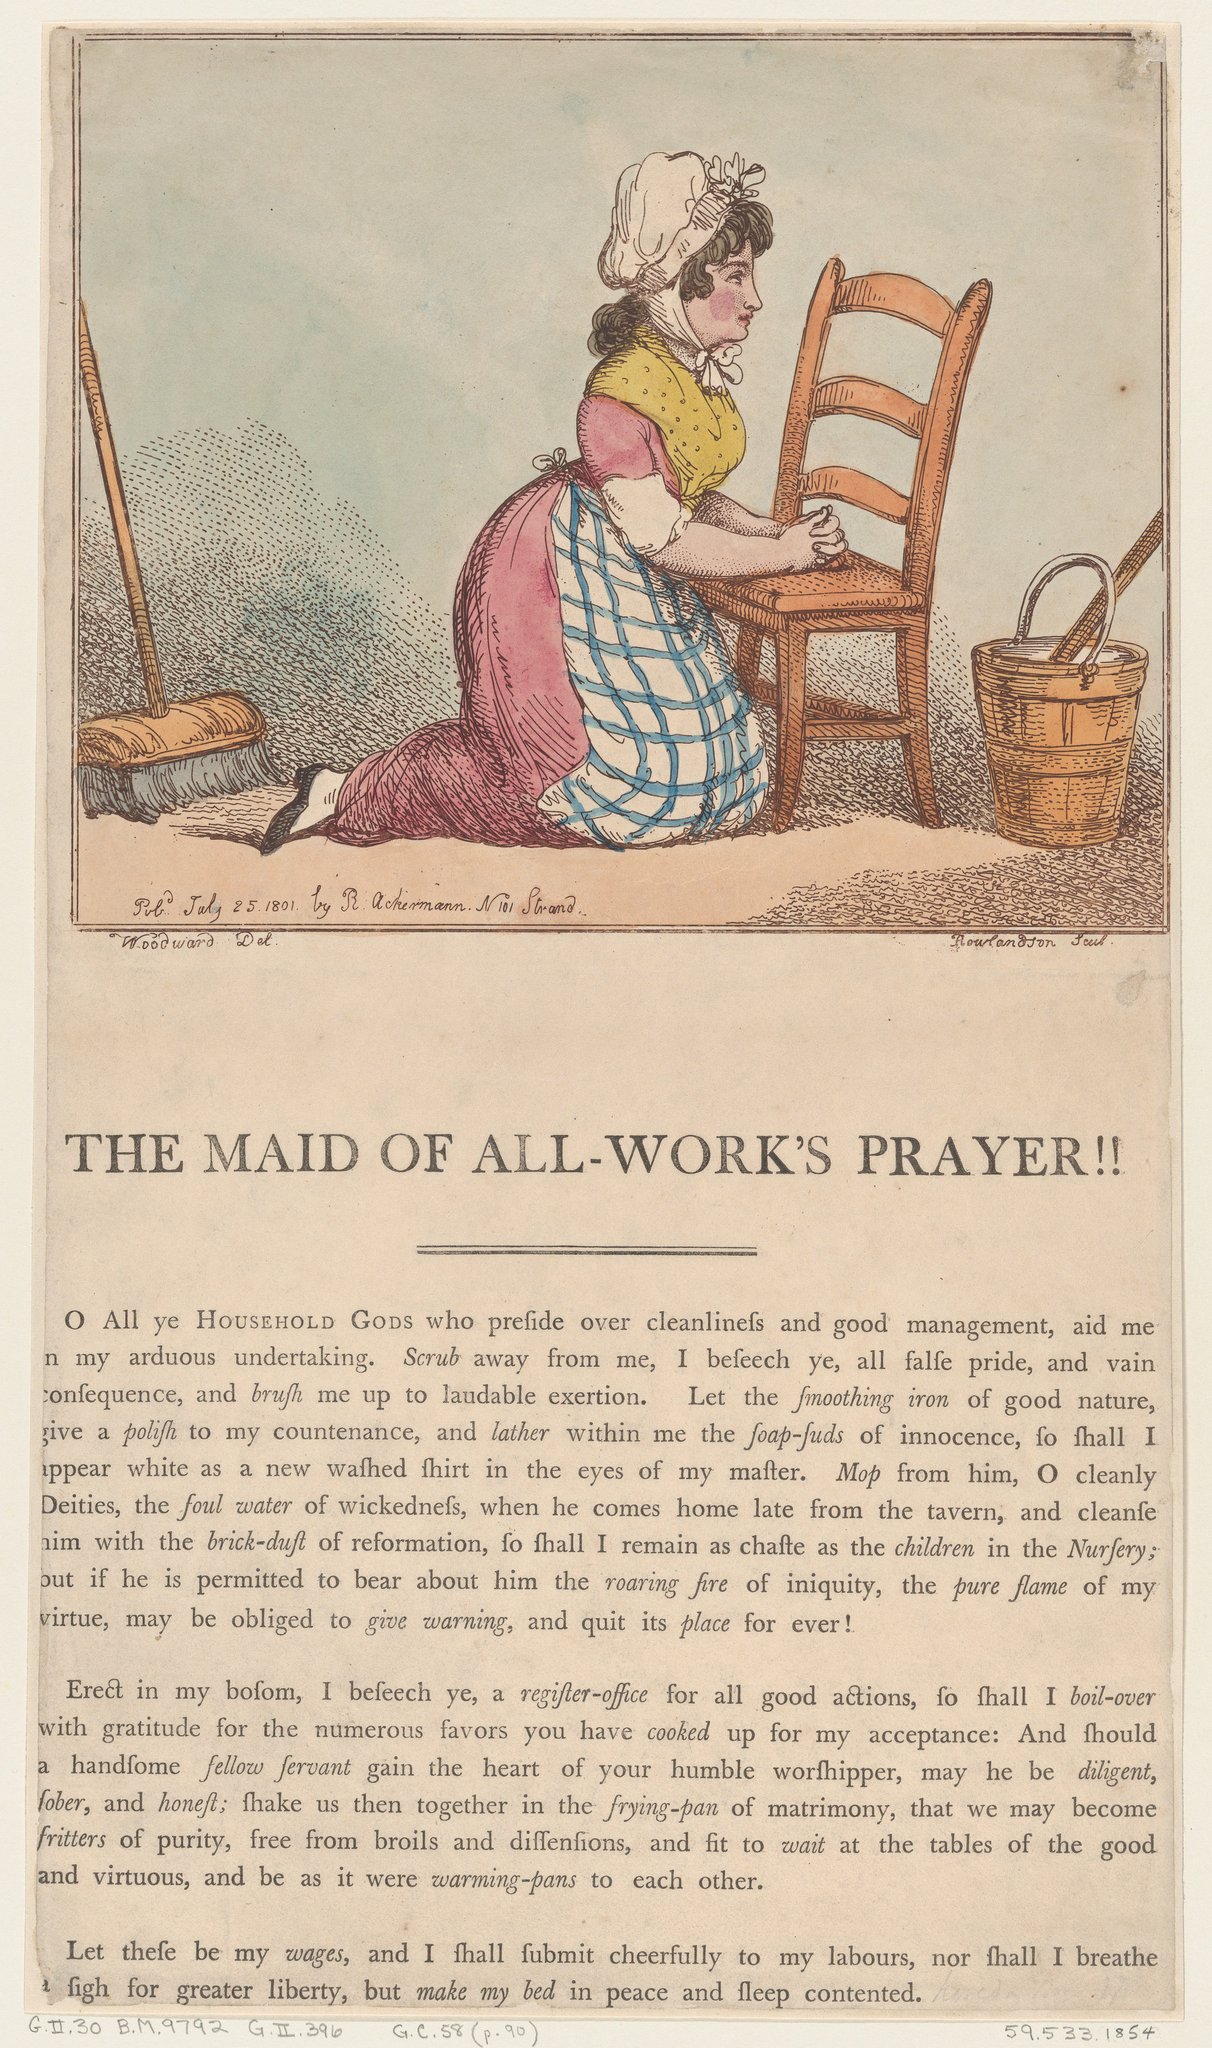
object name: print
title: The Maid of All-Work's Prayer!!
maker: thomas rowlandson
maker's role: artist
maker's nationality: british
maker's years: 1757-1827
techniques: etching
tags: satire,women,servants